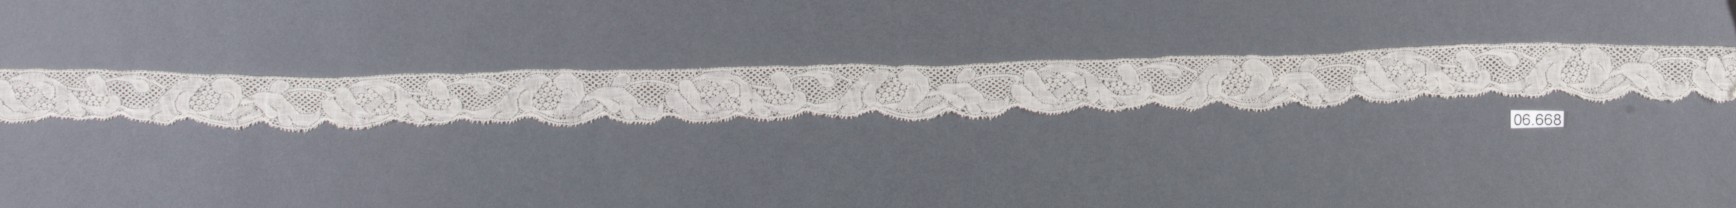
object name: fragment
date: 1701-1733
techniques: lace